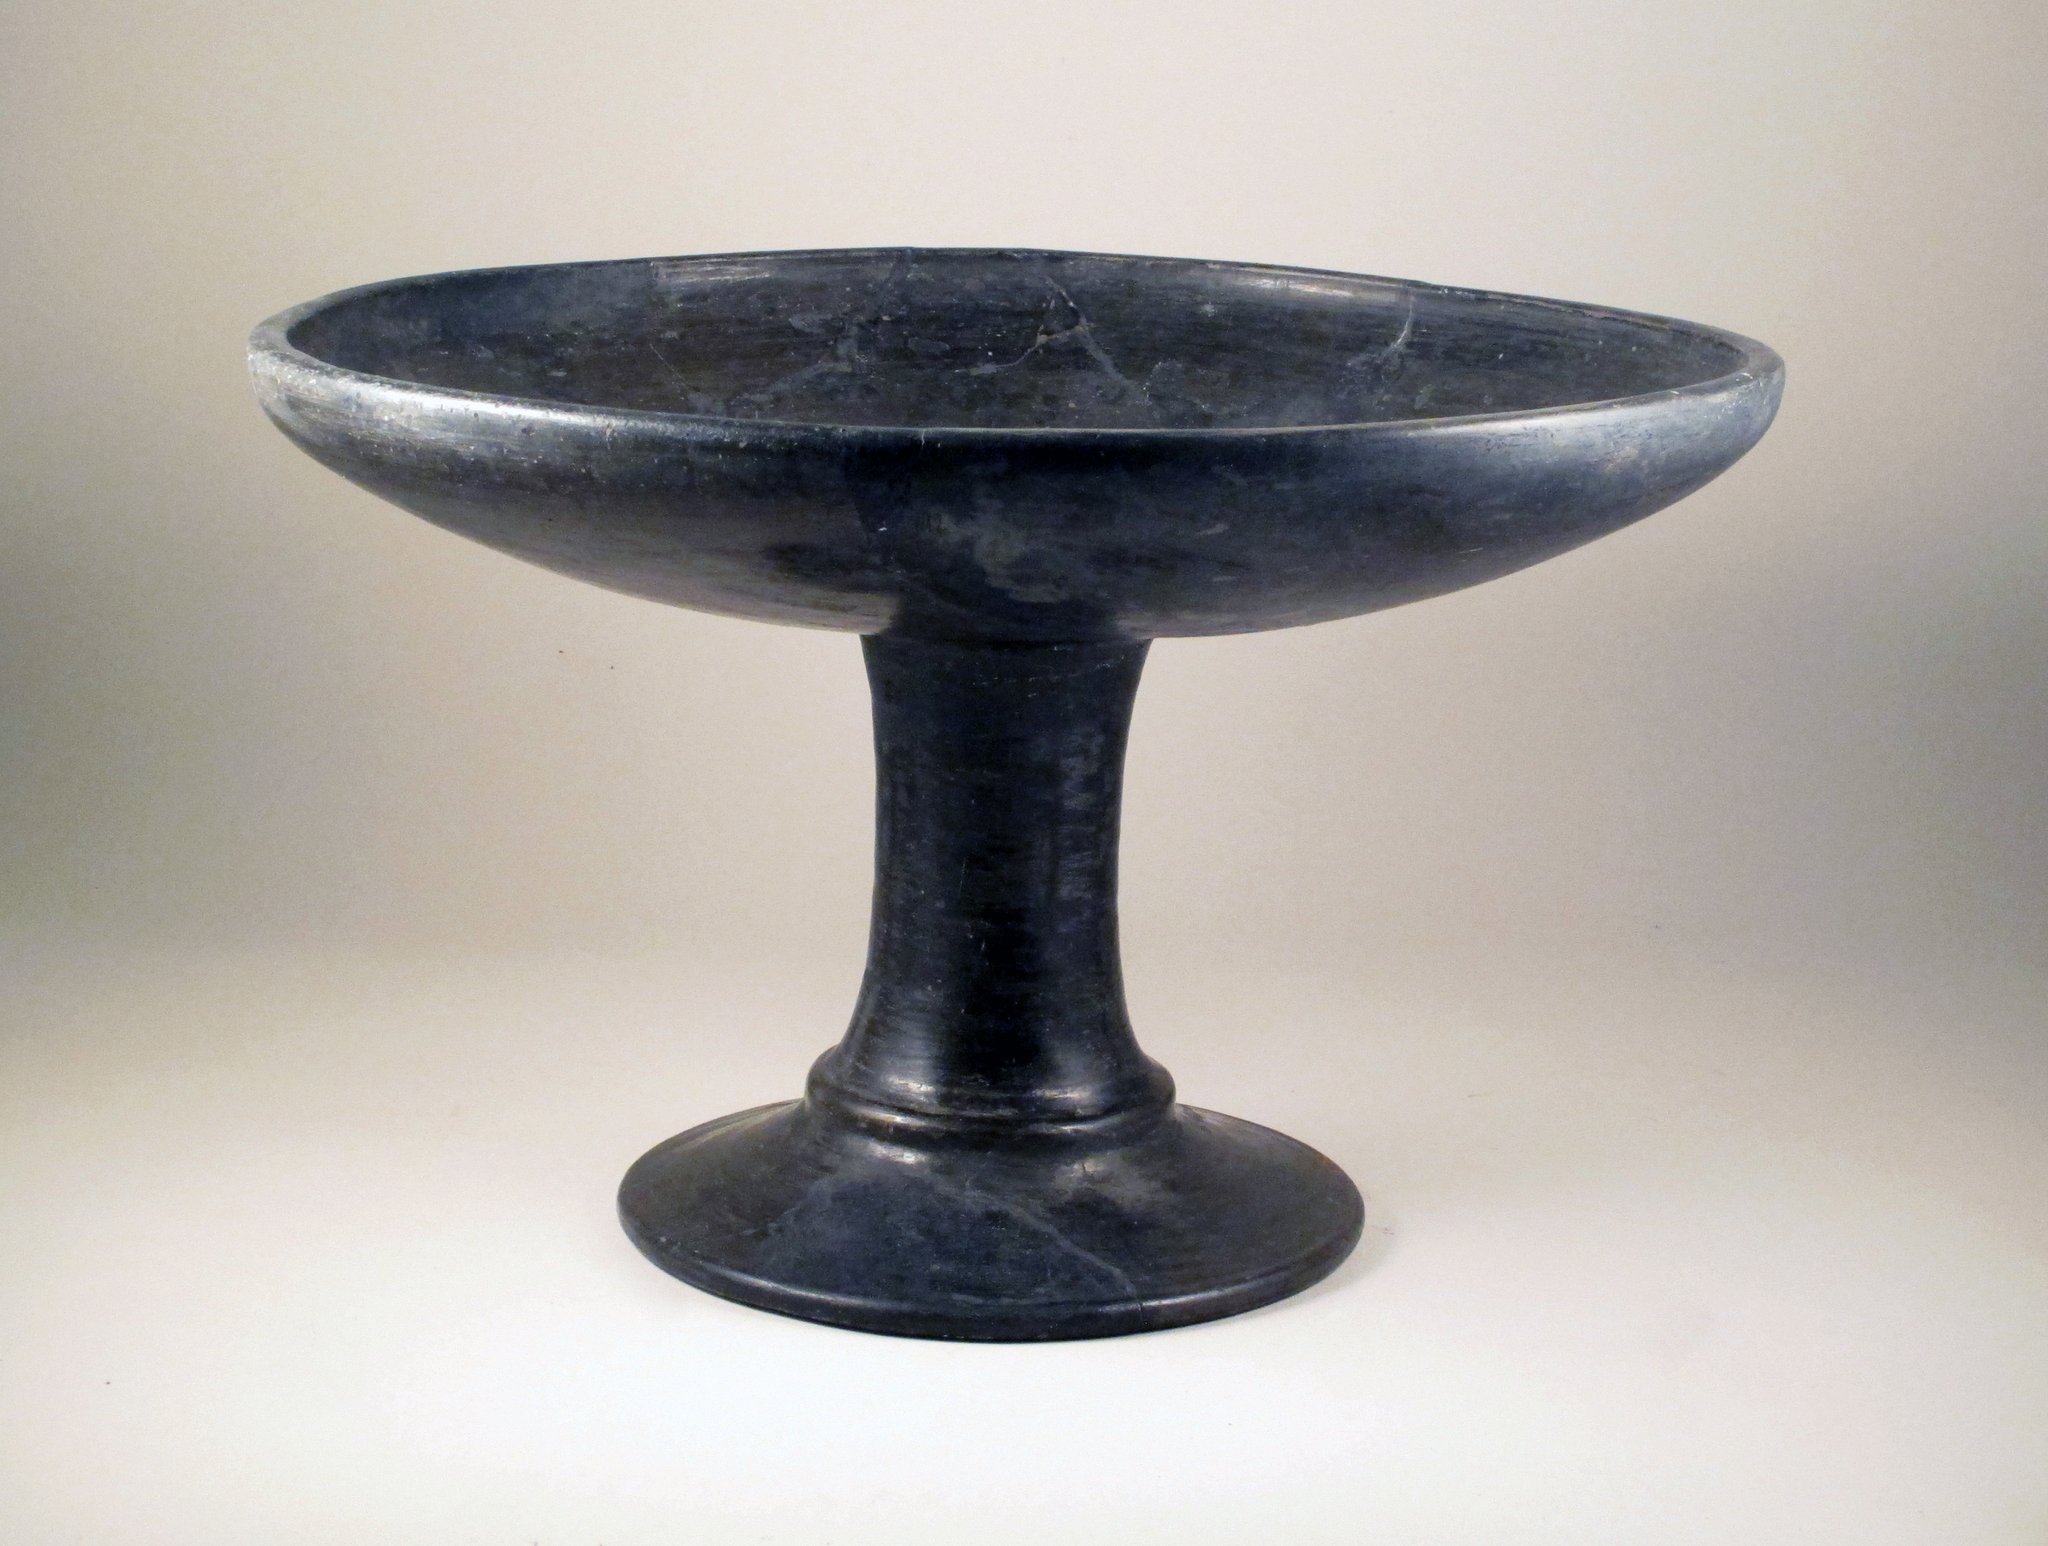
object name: plate, stemmed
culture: greek or lydian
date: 900-30 BCE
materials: terracotta